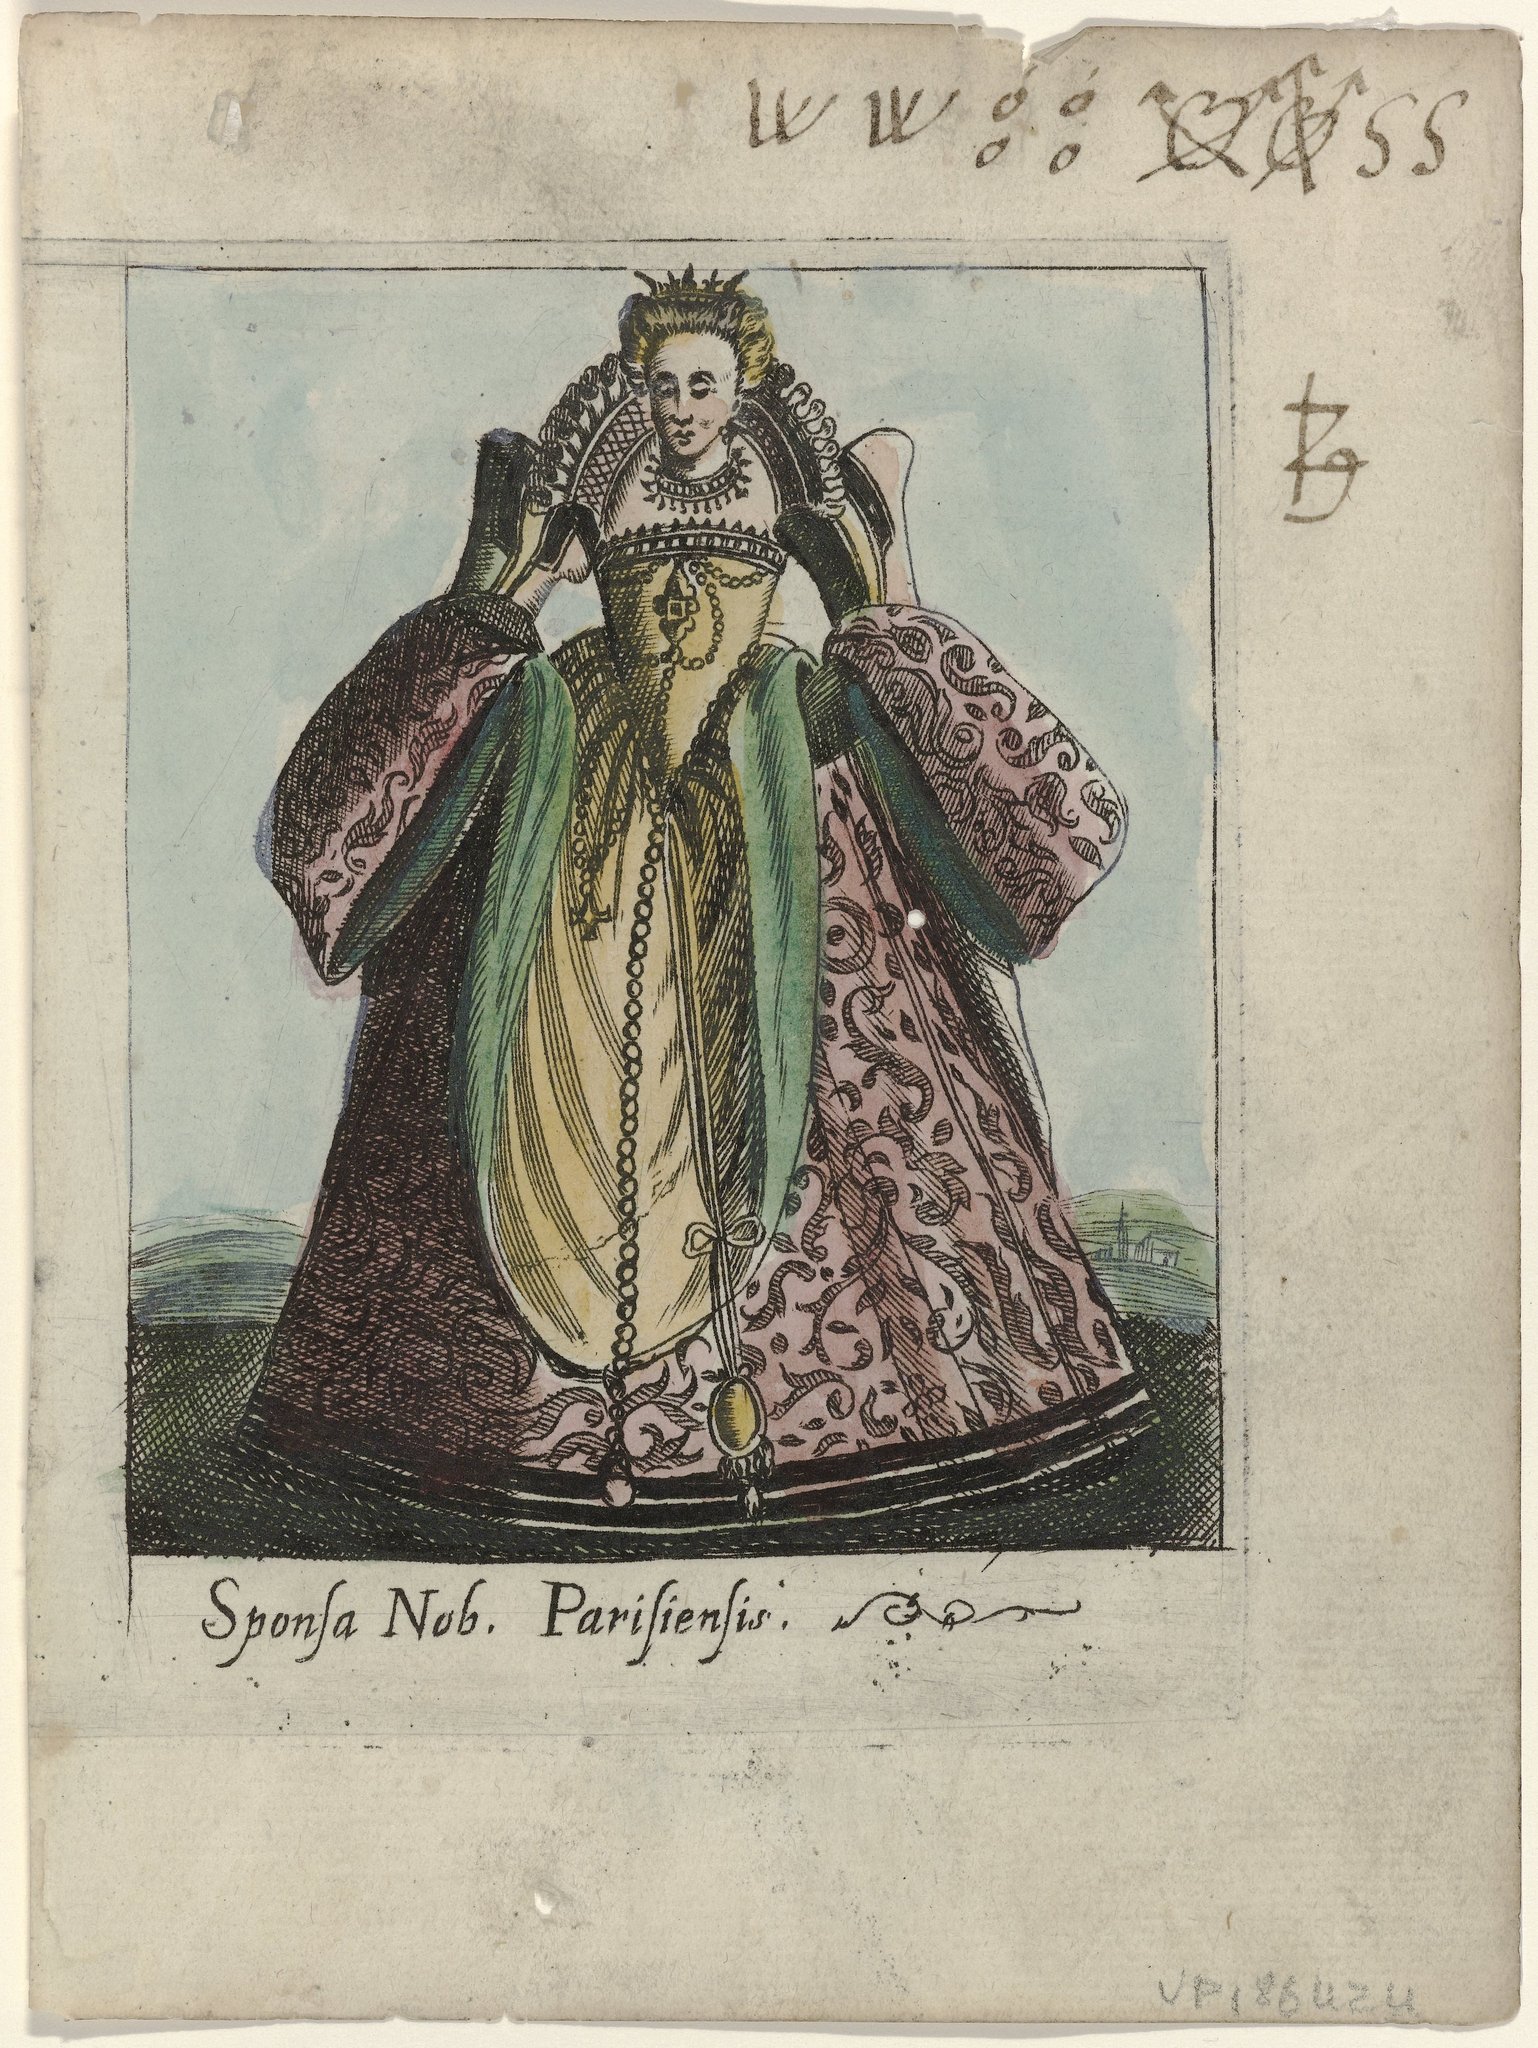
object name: costume print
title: Diversarum Nationum habitus (...)Padua, 1592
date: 1592-1594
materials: paper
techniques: engraving, hand coloring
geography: italy